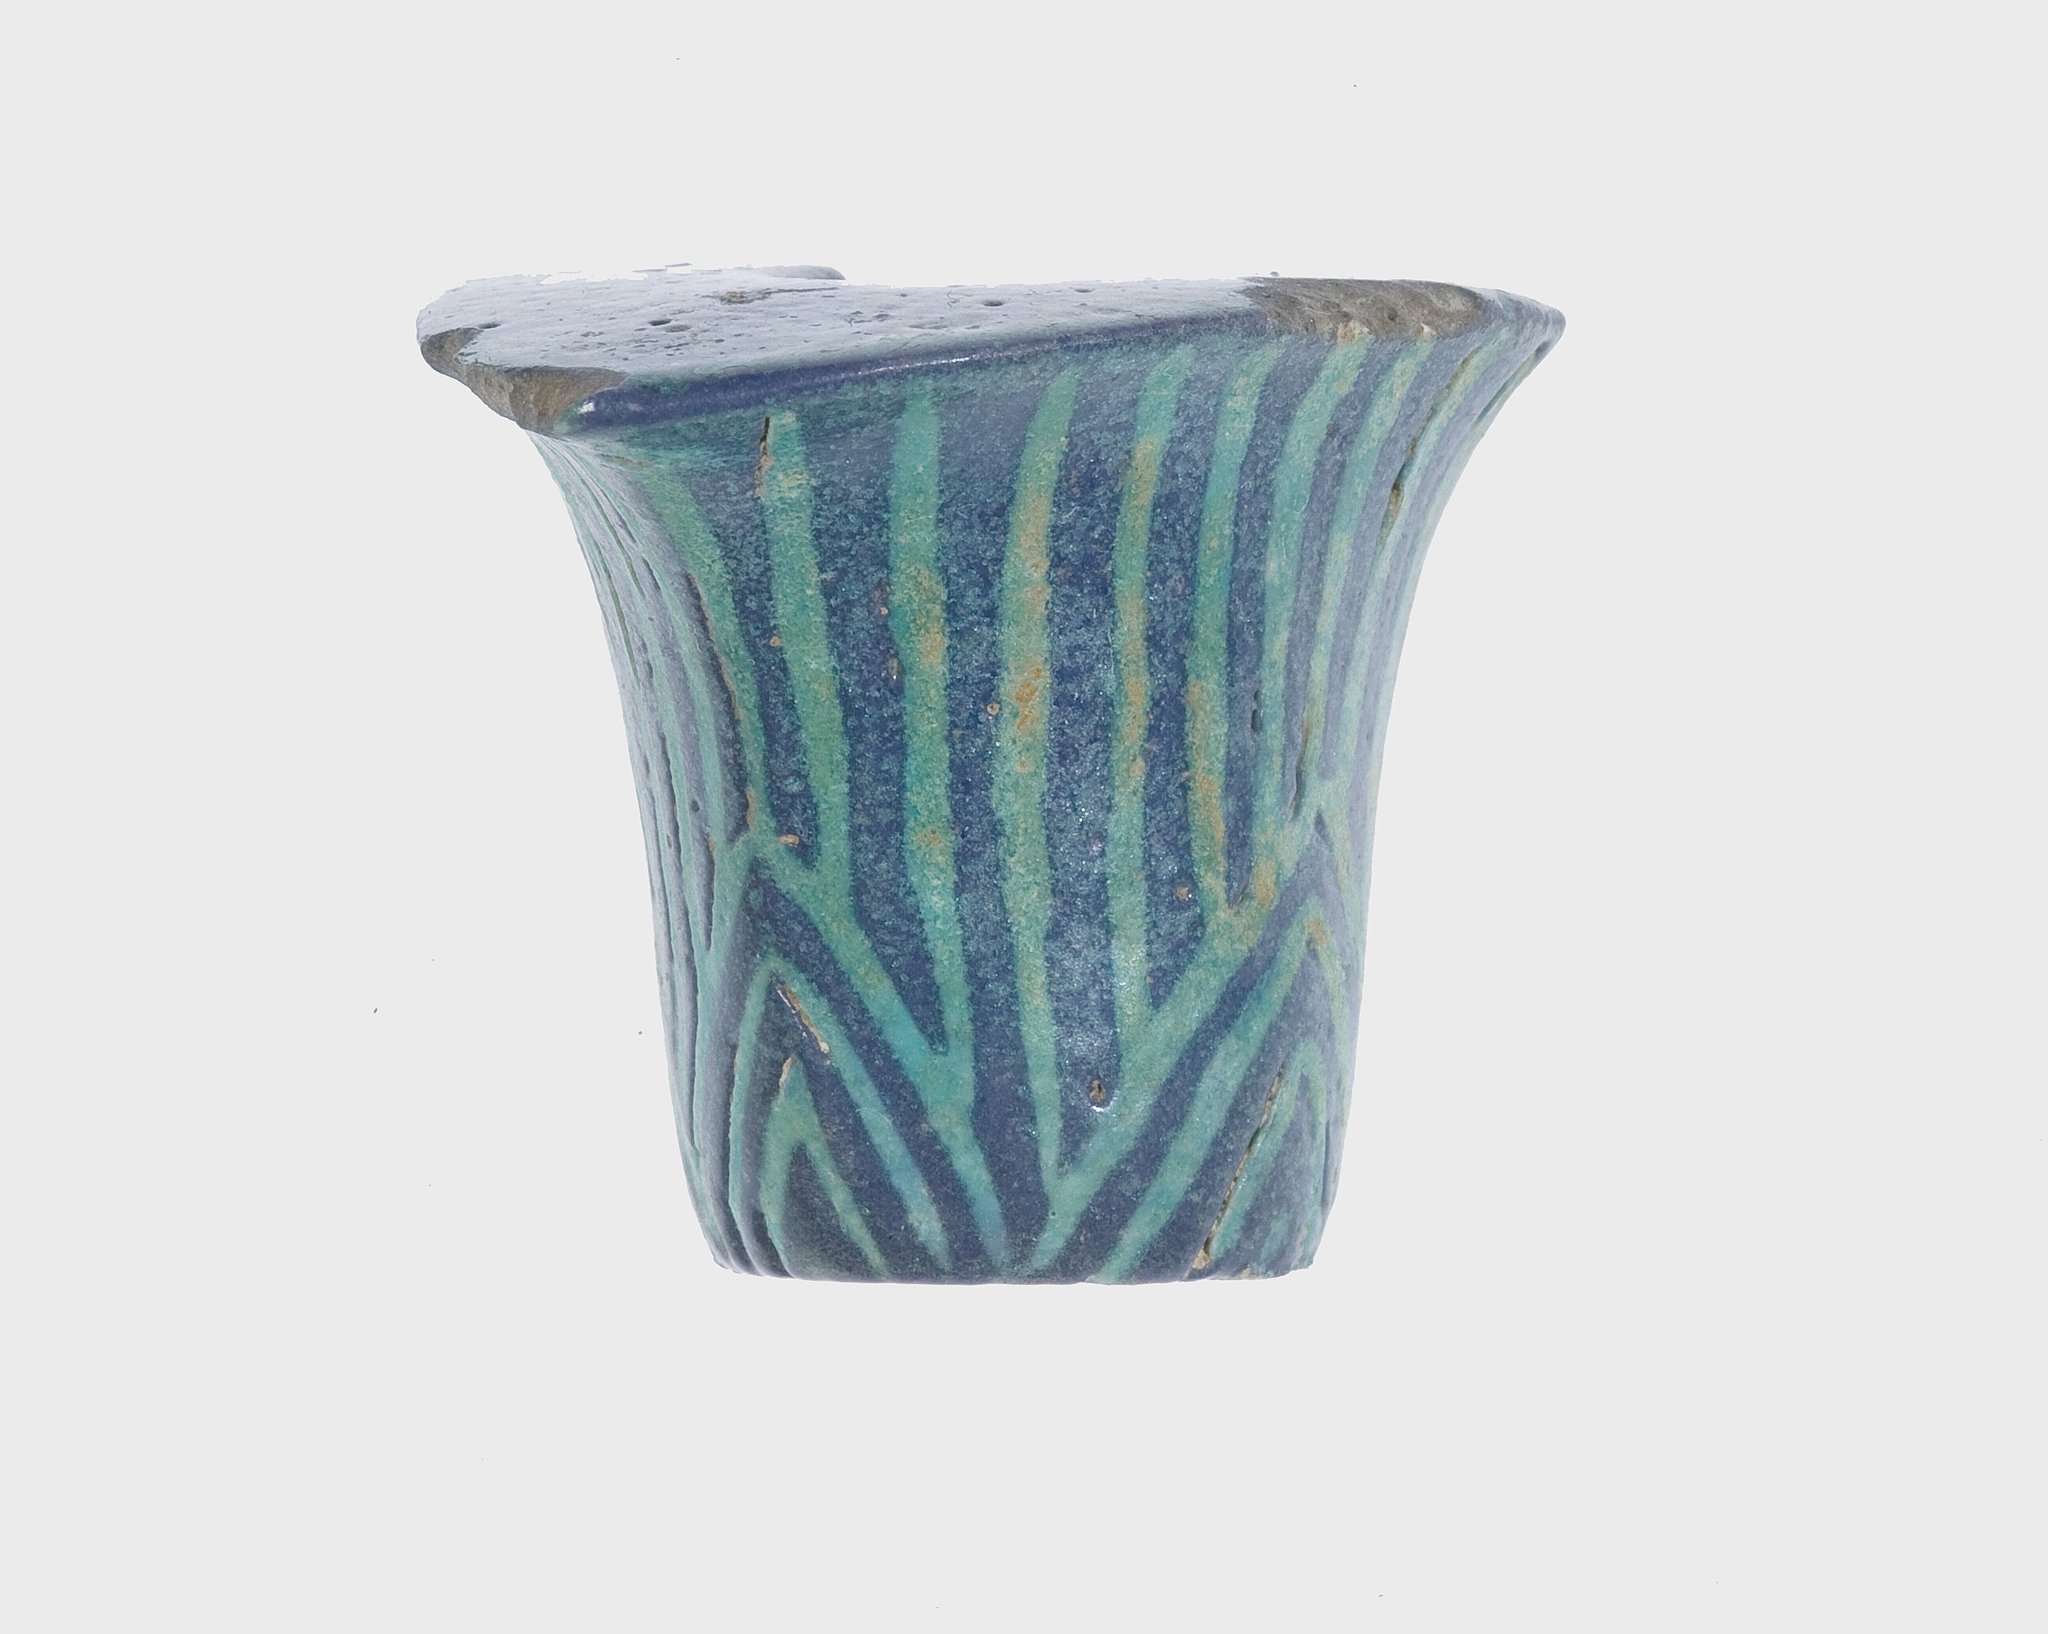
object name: mirror handle, papyrus umbel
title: Upper Part of Papyrus Stalk Mirror Handle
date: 1390-1352 BCE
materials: faience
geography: egypt